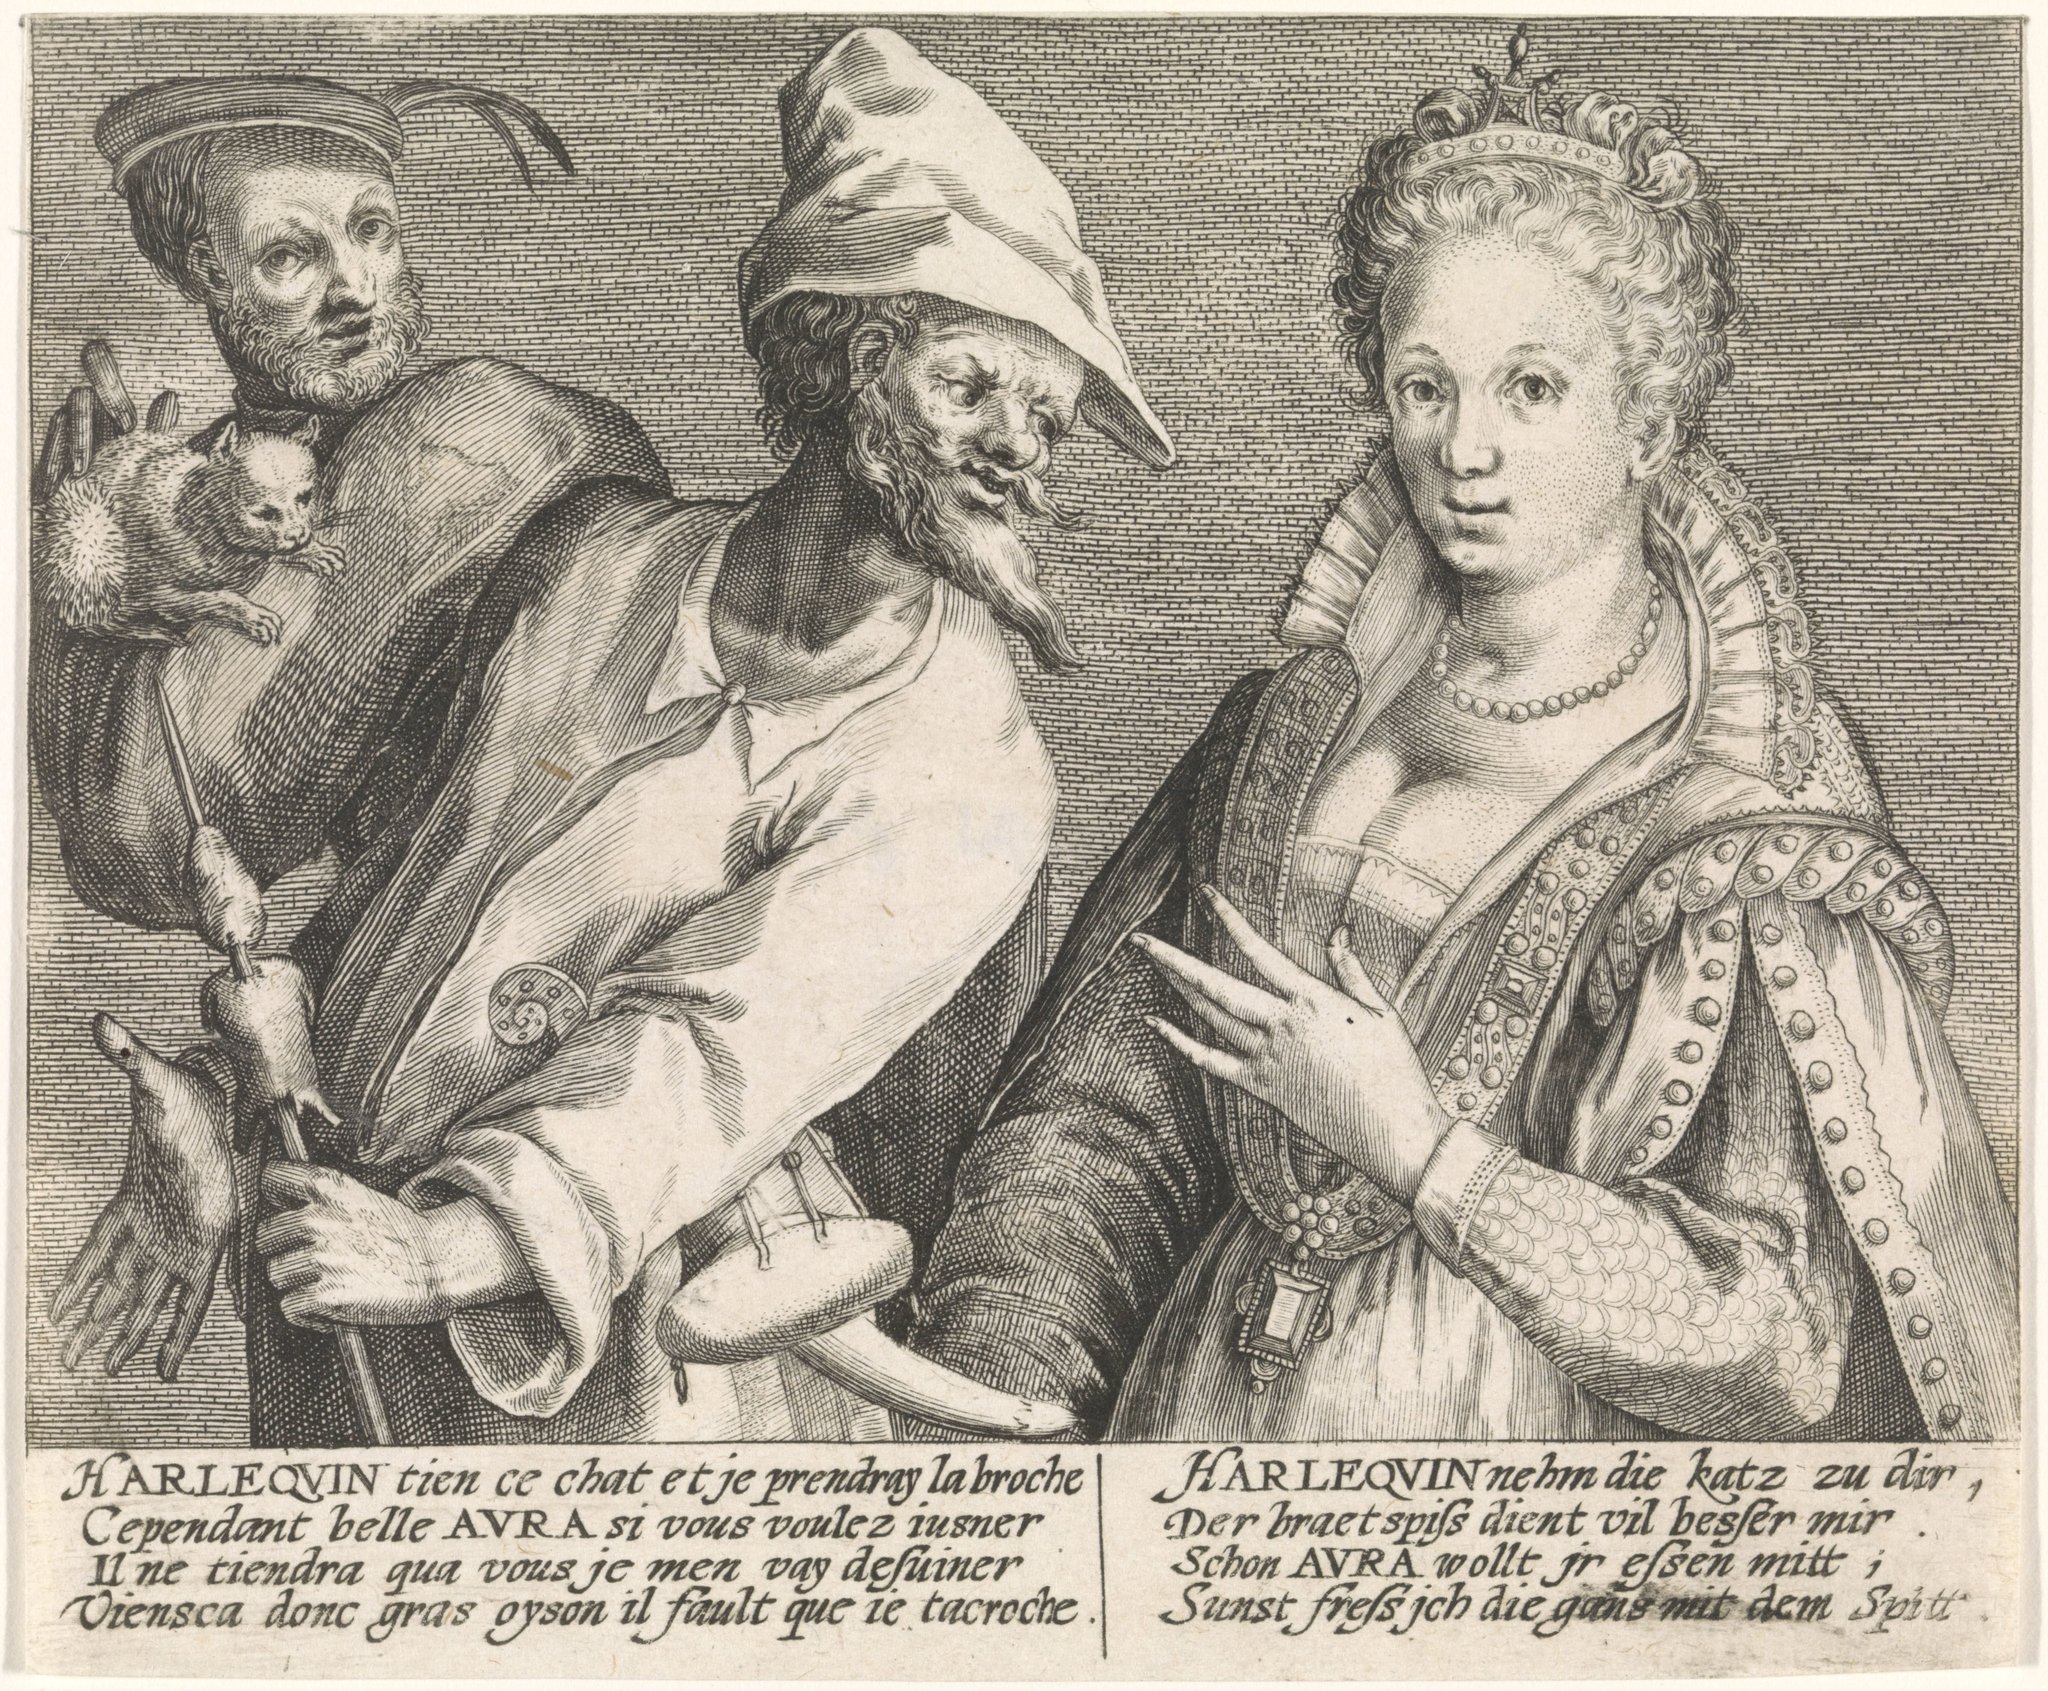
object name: print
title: Aura probeert Harlekijn te verleiden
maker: crispijn van de passe (i)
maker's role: draughtsman, print maker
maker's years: 1564-1637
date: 1574-1637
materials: paper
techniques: engraving, etching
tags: cat, unsuccessful love affair; seduction, types in 'commedia dell'arte': harlequin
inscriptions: collector's mark: Lugt 2161, collector's mark: Lugt 2228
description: Een rijkgeklede vrouw (Aura) en Harlekijn (een personage uit de Commedia dell'arte), vergezeld door een man die een kat vasthoudt. Volgens het vierregelig gedicht in de marge (in het Frans en in het Duits) vraagt Aura aan Harlekijn om de kat (symbool voor het vrouwelijk geslachtsdeel) te pakken, terwijl zij voor het spit (symbool voor het mannelijk geslachtsdeel) kiest.